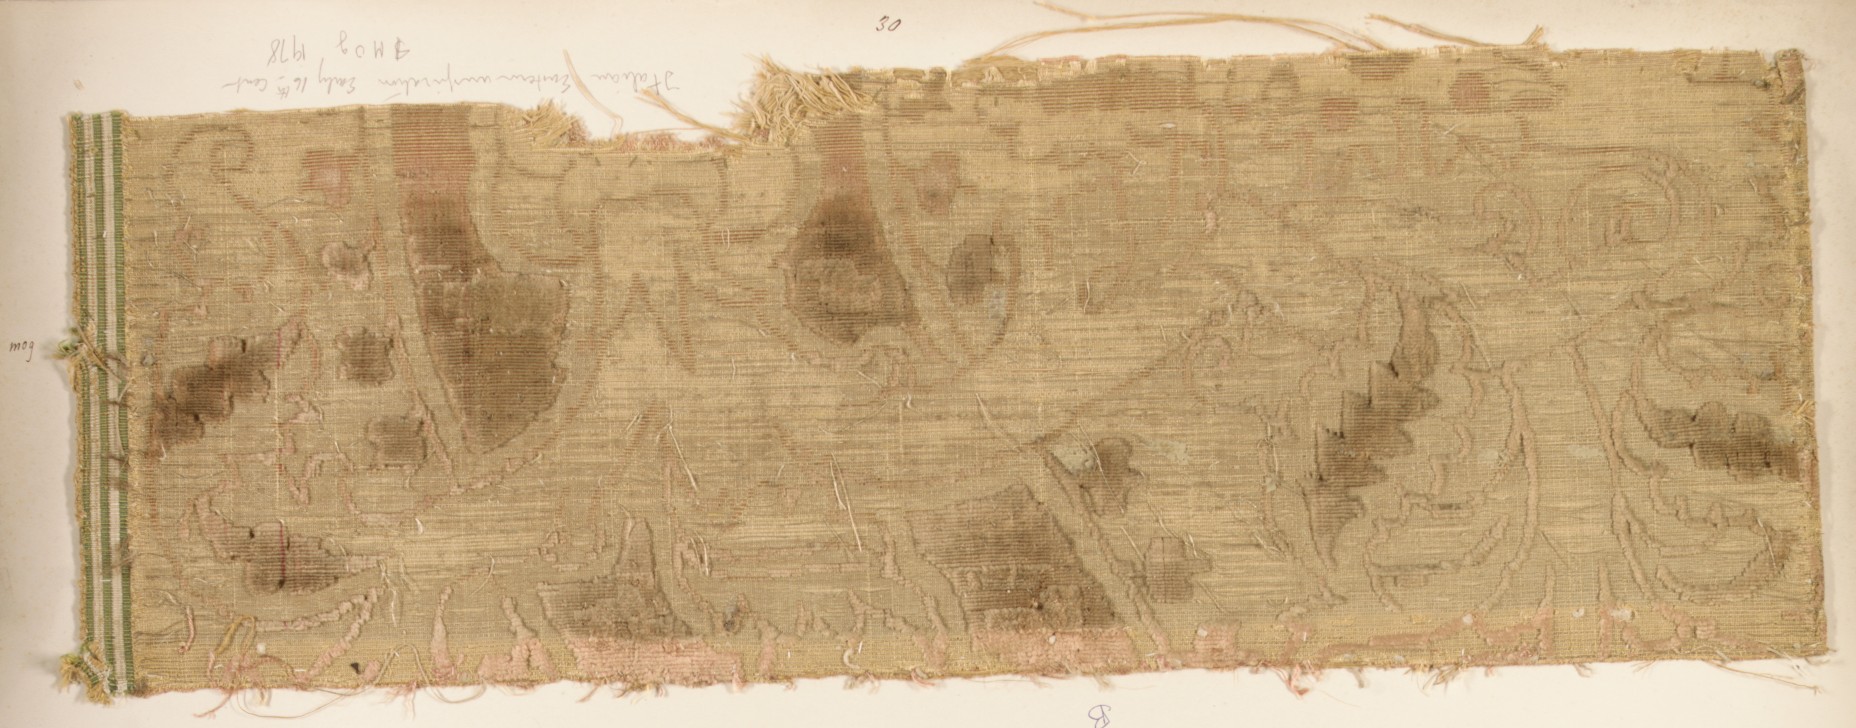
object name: fragment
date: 1401-1500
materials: metal thread, silk